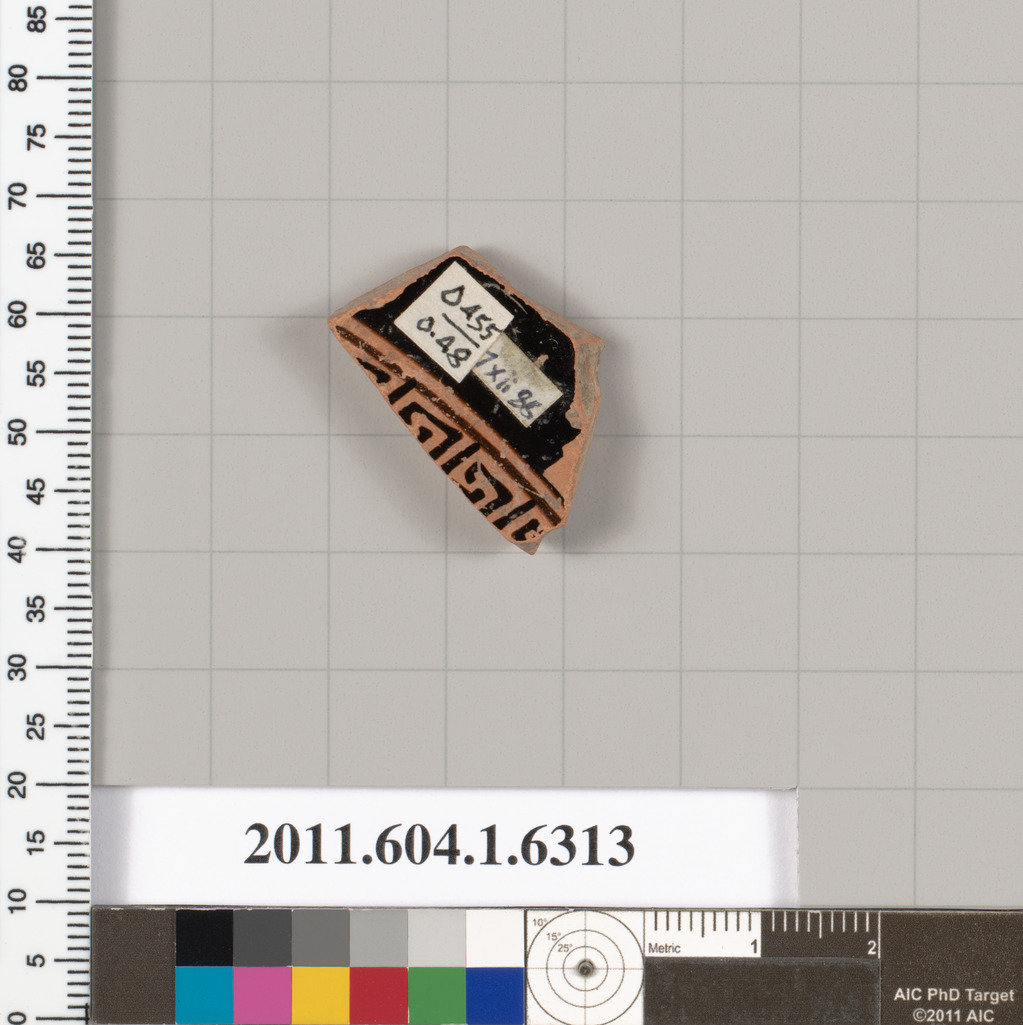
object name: kylix fragment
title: Terracotta fragment of a kylix (drinking cup)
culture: greek, attic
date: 500-480 BCE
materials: terracotta